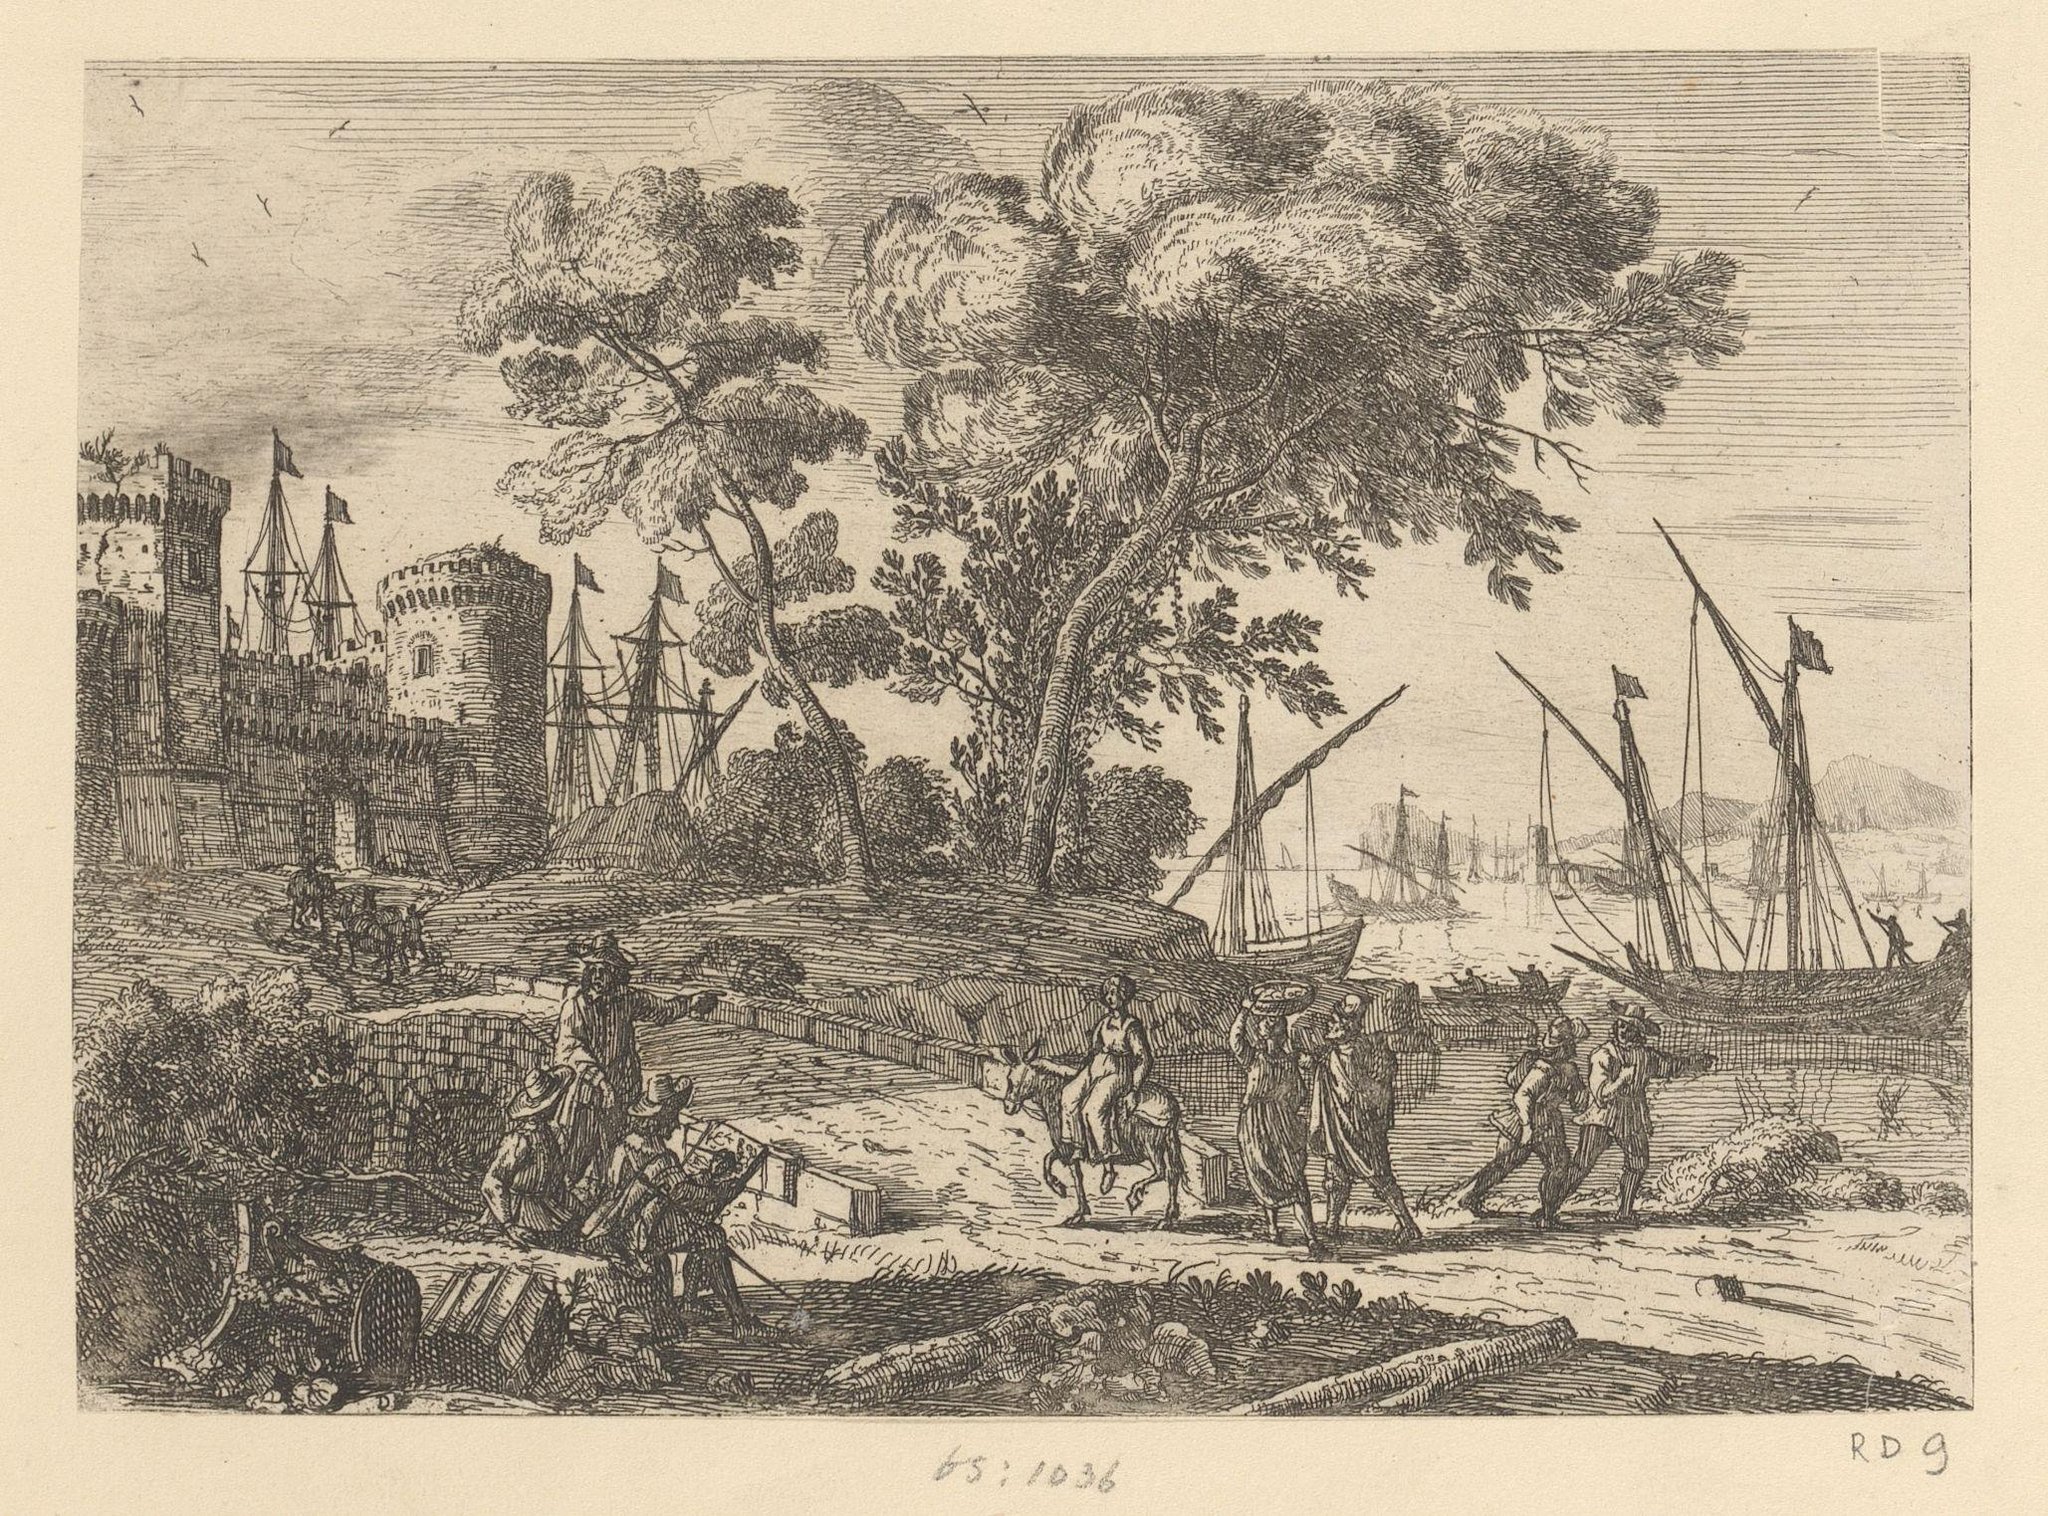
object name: album leaf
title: Le Dessinateur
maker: claude lorrain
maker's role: draughtsman, print maker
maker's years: 1604-1682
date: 1638-1641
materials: paper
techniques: etching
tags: harbour, artist (in general) making preliminary designs, sketching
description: Prent maakt mogelijk deel uit van een serie van 200 prenten. Deze serie is onder de titel 'A Collection of two hundred original etchings' voor het eerst uitgegeven door J.M. Greery in 1816.